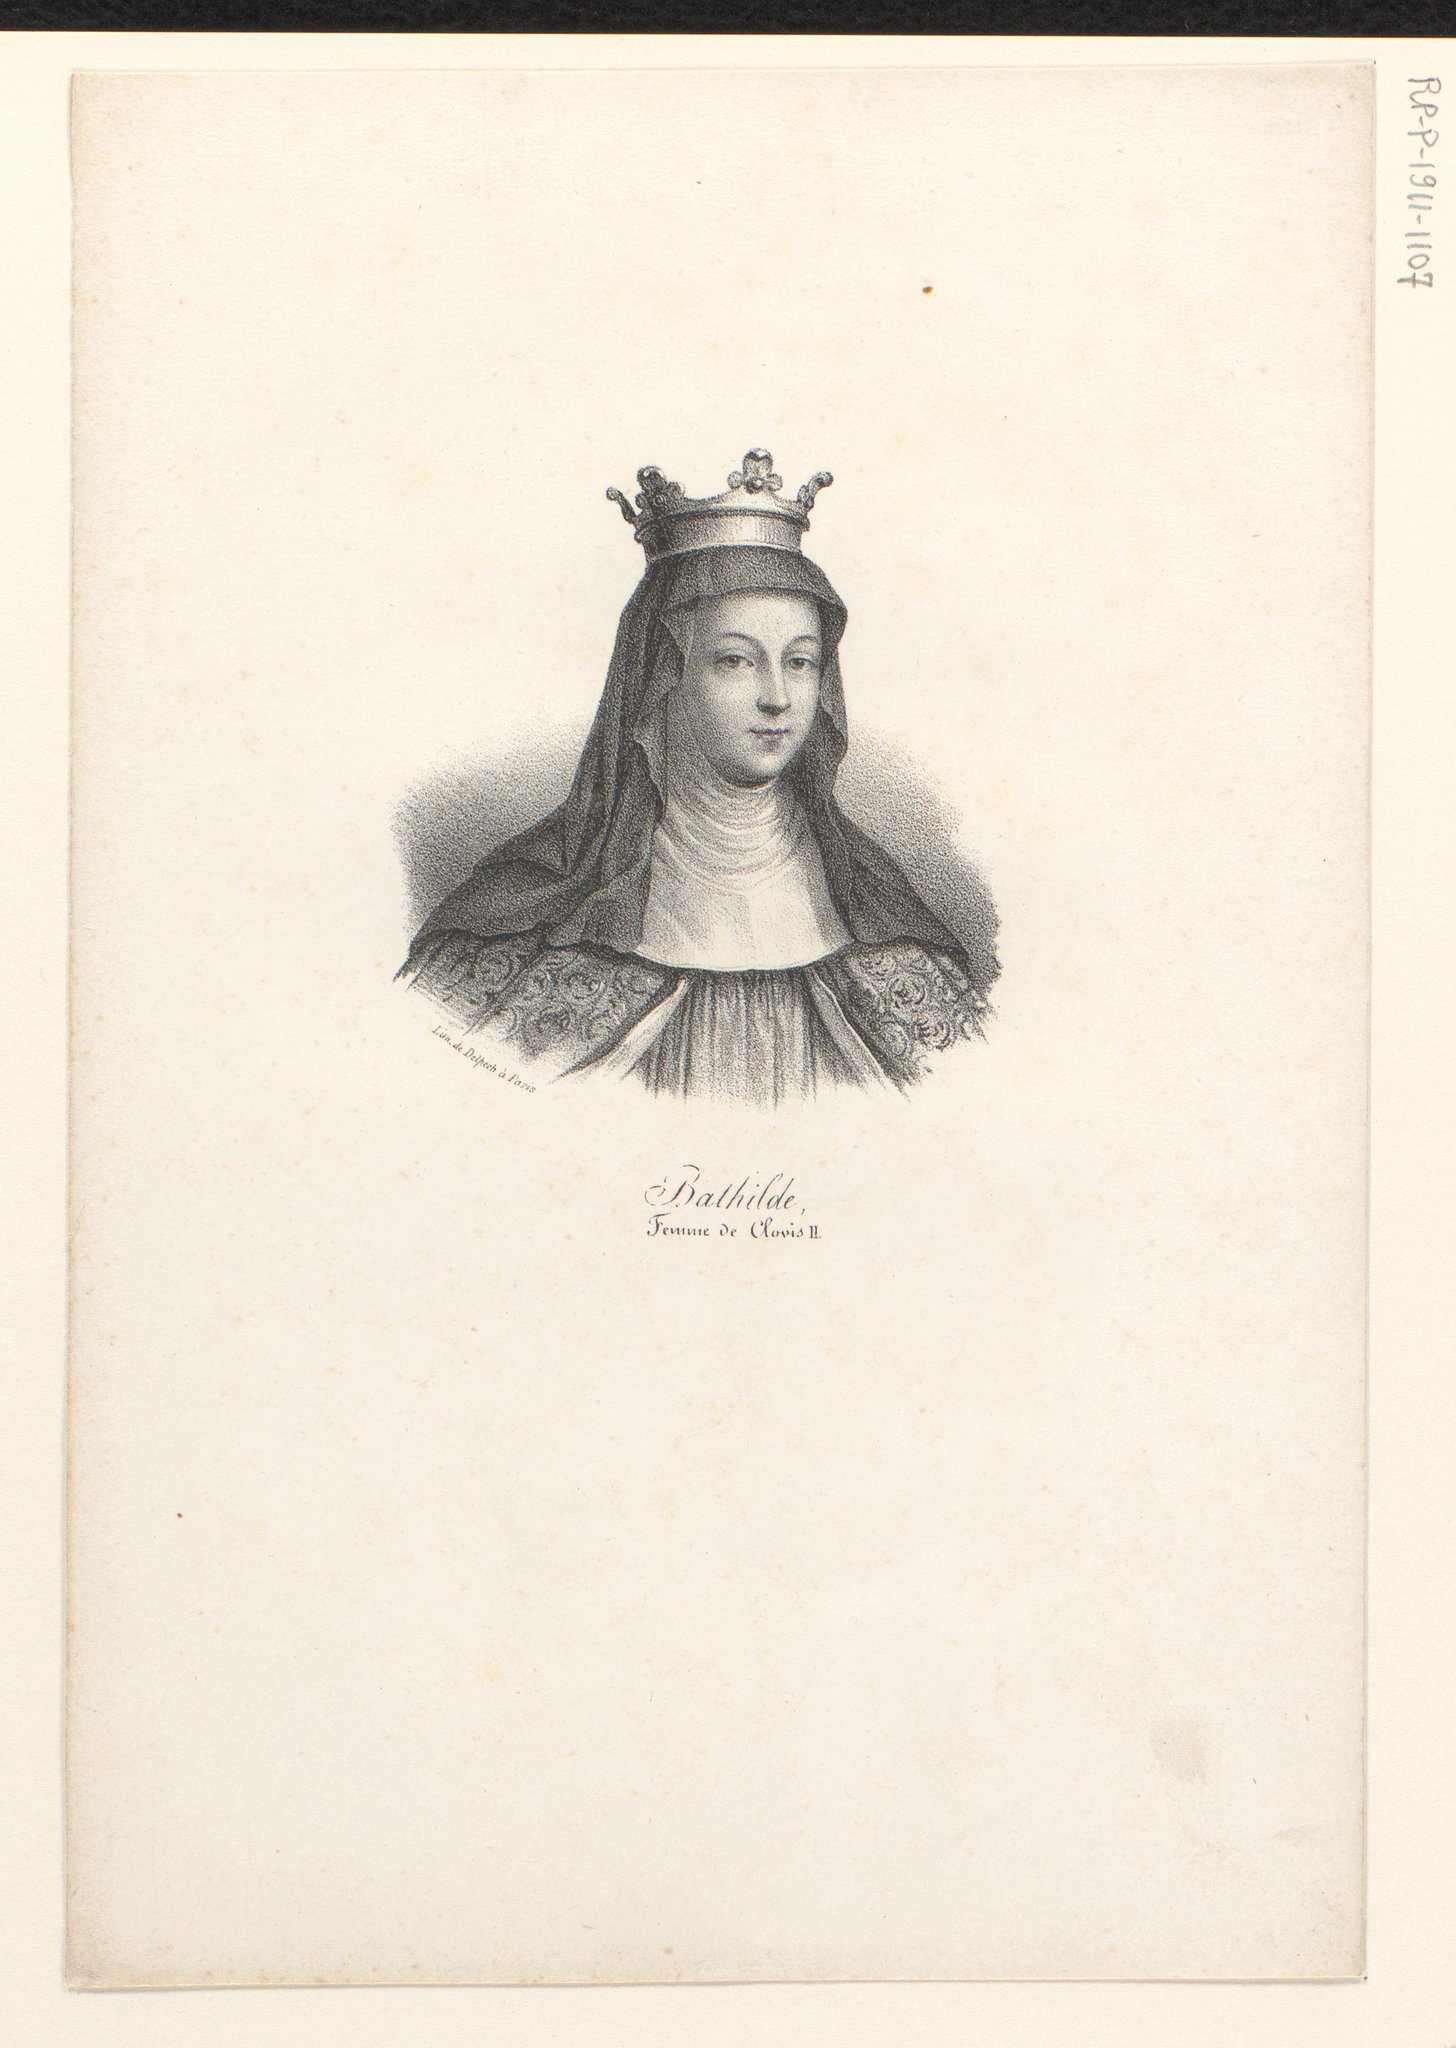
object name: print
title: Portret van Bathilde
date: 1818-1842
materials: paper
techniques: lithograph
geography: paris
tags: historical persons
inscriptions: collector's mark: Lugt 2228a